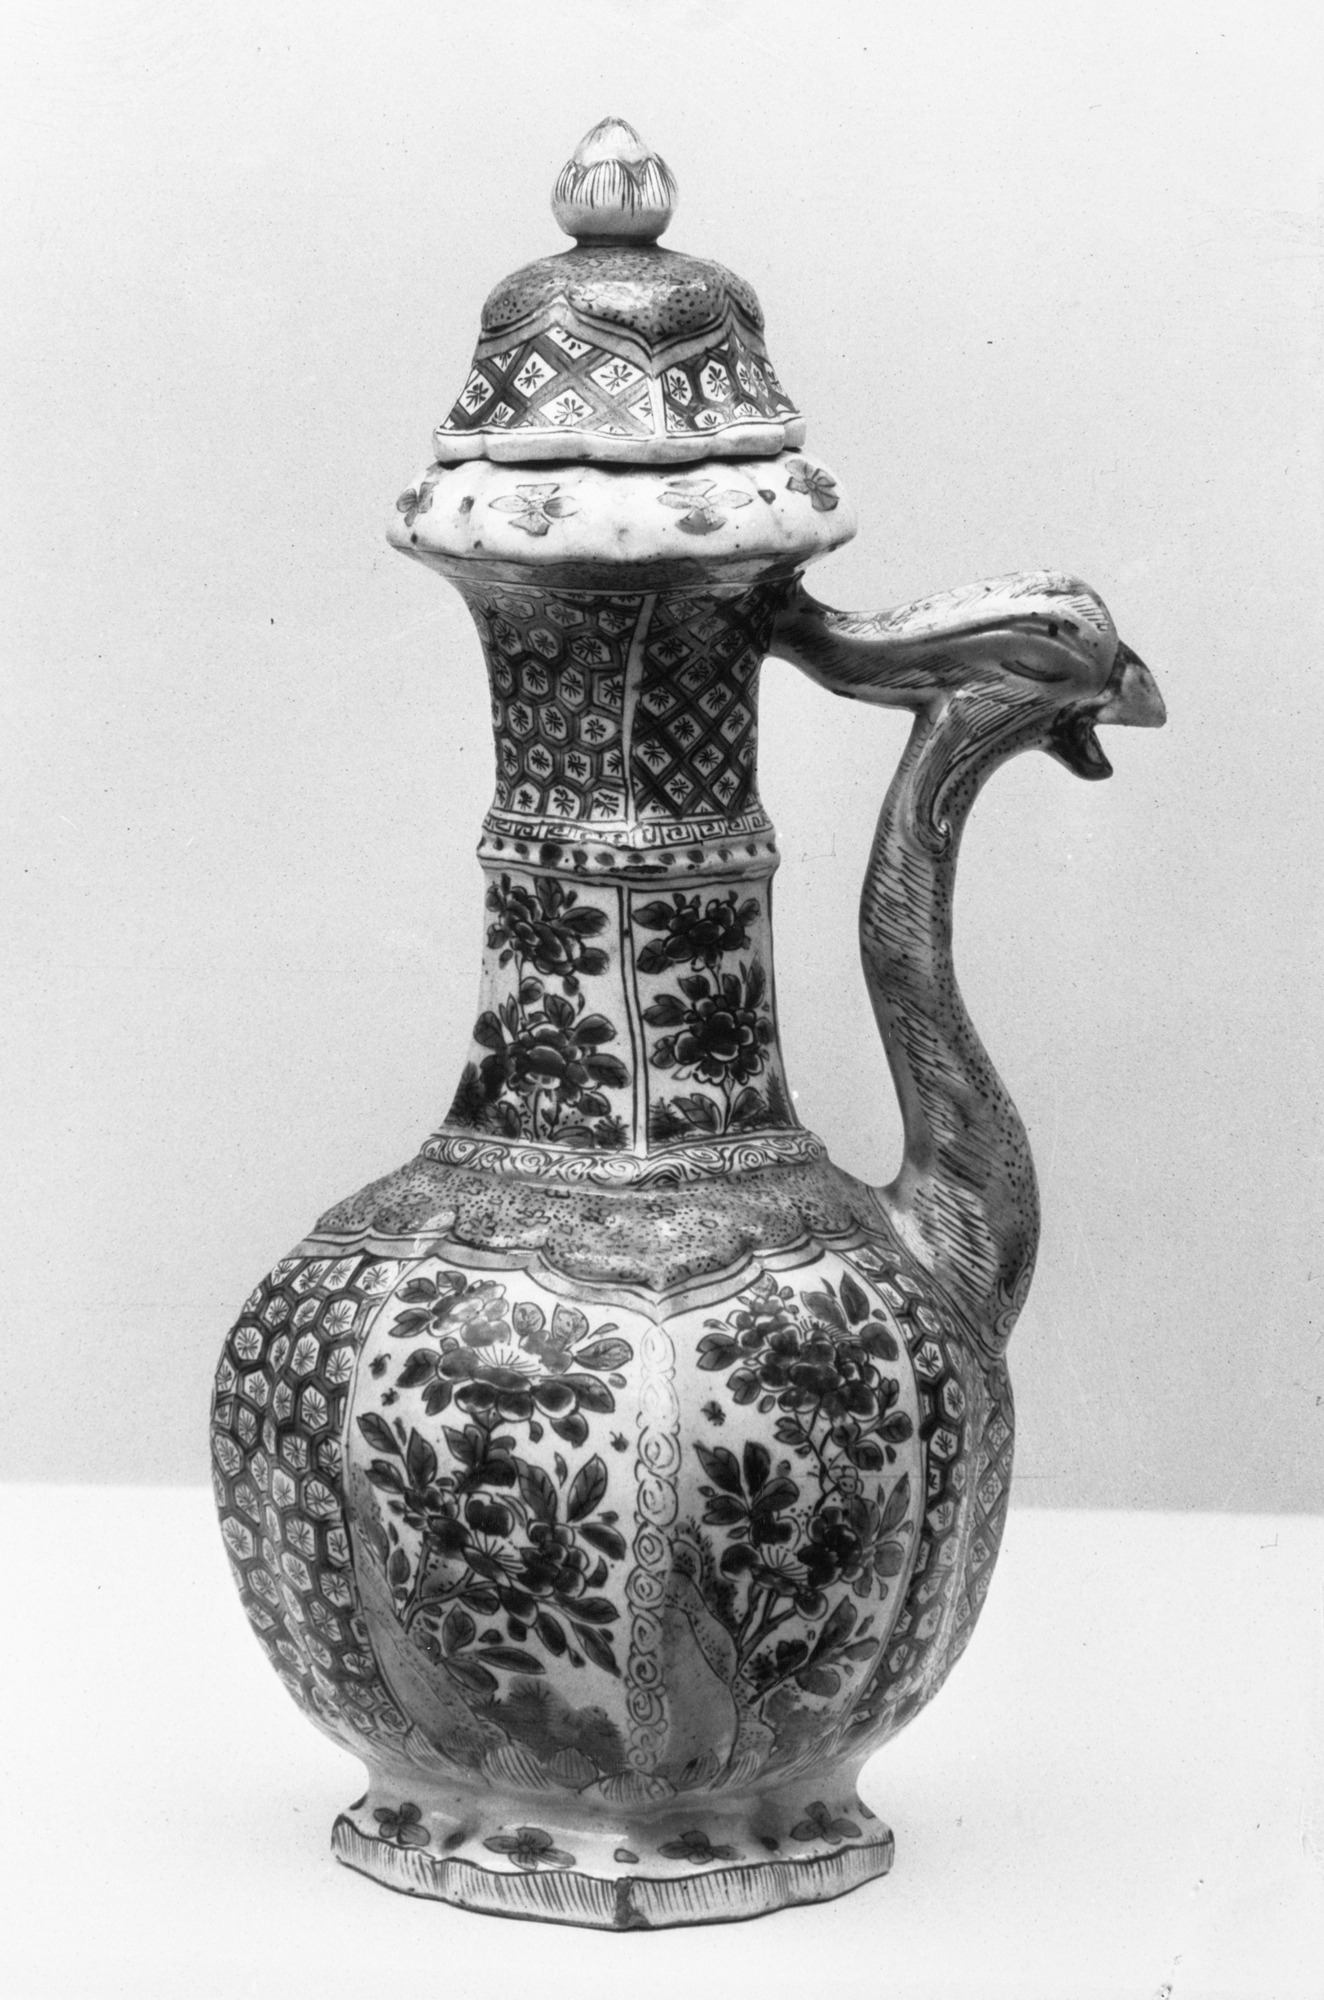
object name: wine pot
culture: chinese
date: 1662-1722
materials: porcelain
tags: flowers